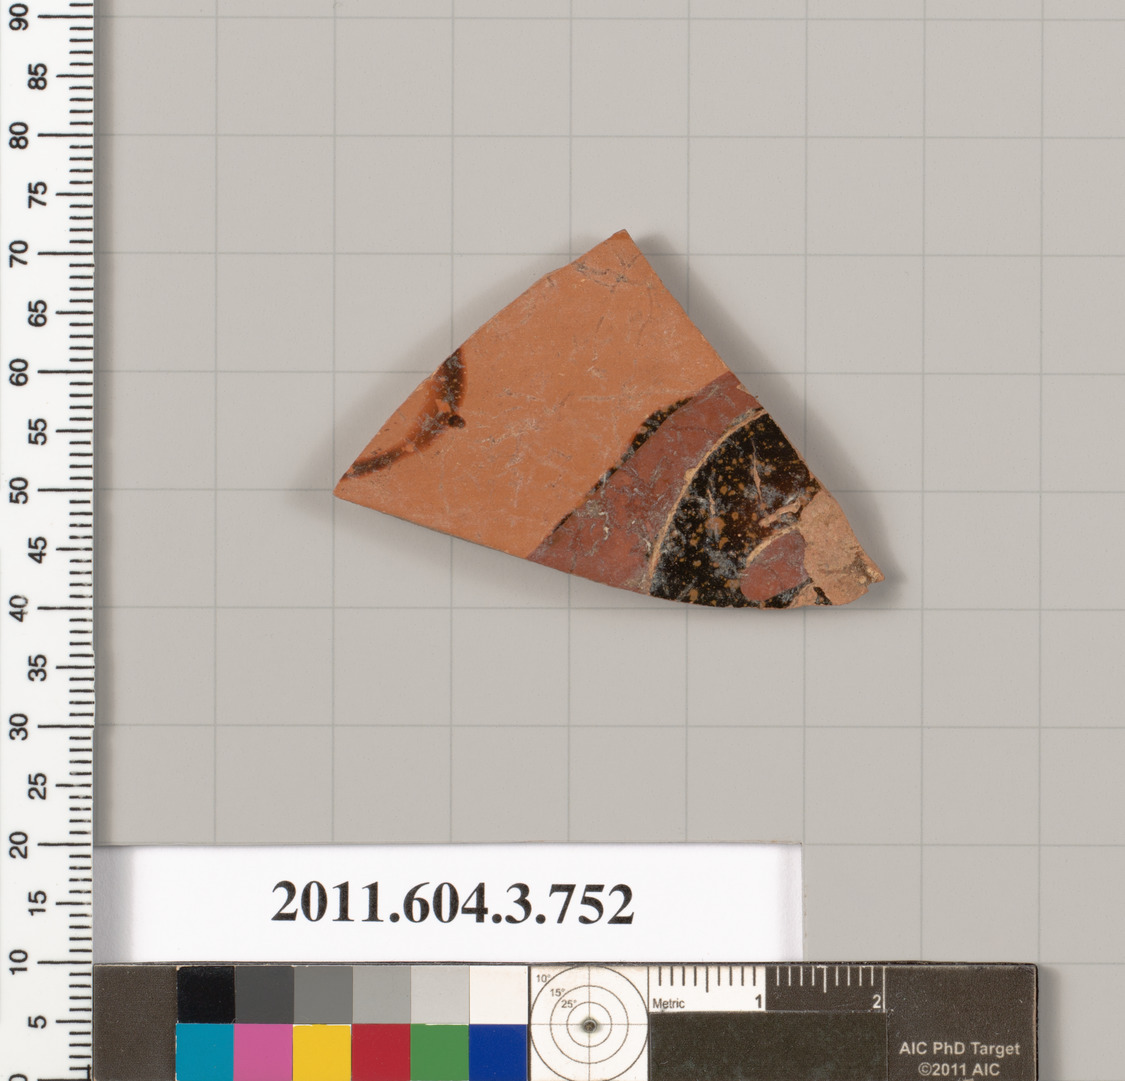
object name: neck amphora, tyrrhenian fragment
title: Terracotta fragment of a neck-amphora (jar)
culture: greek, attic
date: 575-551 BCE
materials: terracotta